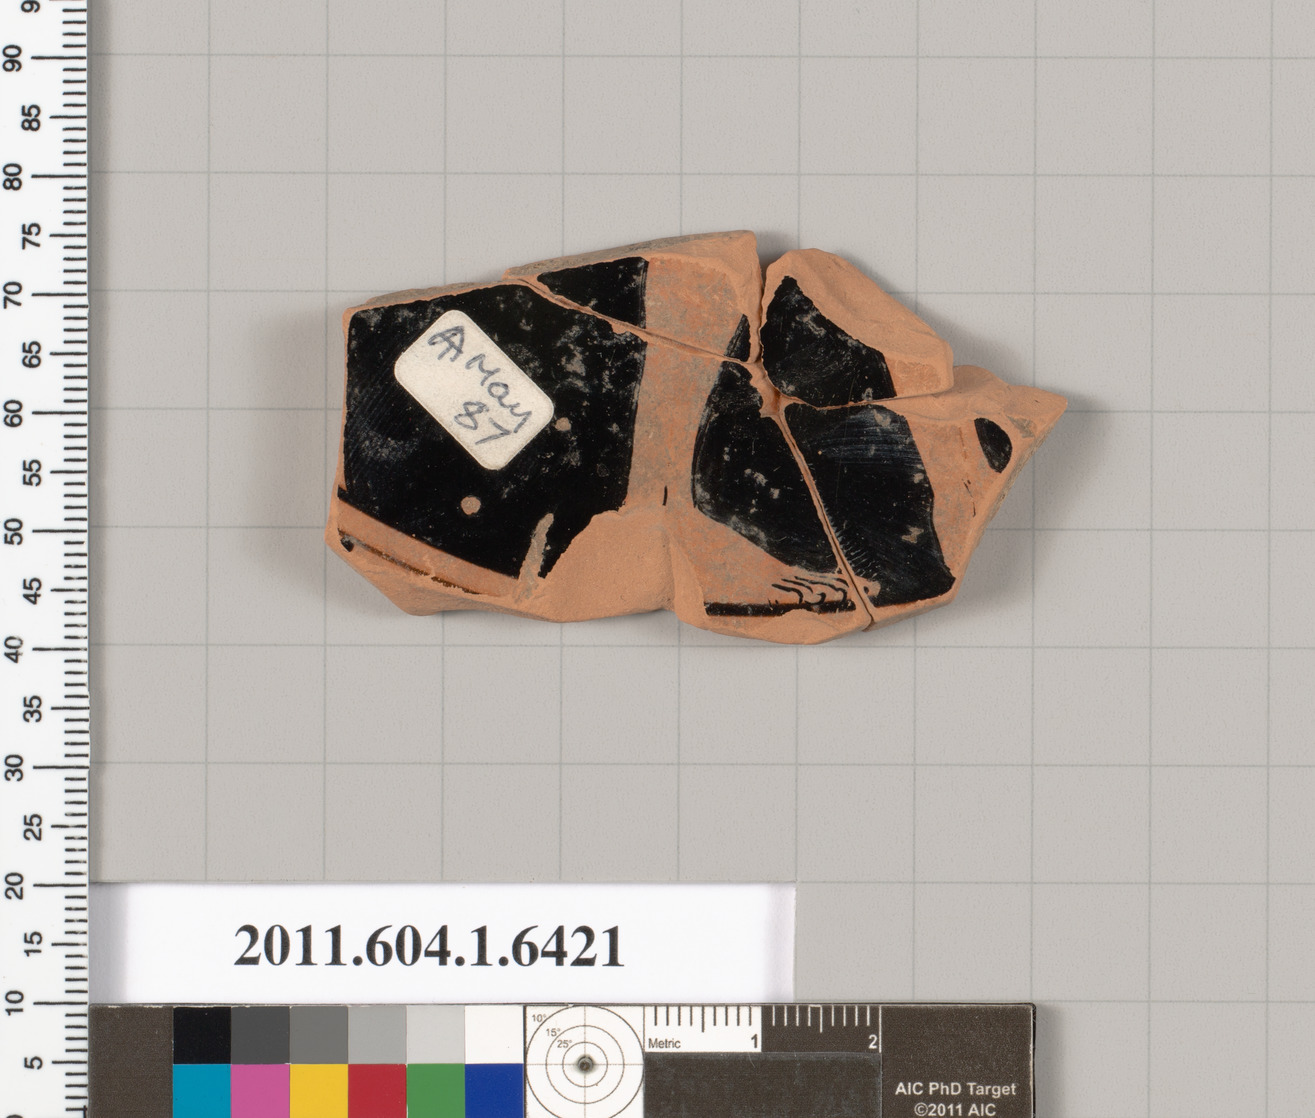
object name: kylix fragment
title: Terracotta fragment of a kylix (drinking cup)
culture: greek, attic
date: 490-480 BCE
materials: terracotta